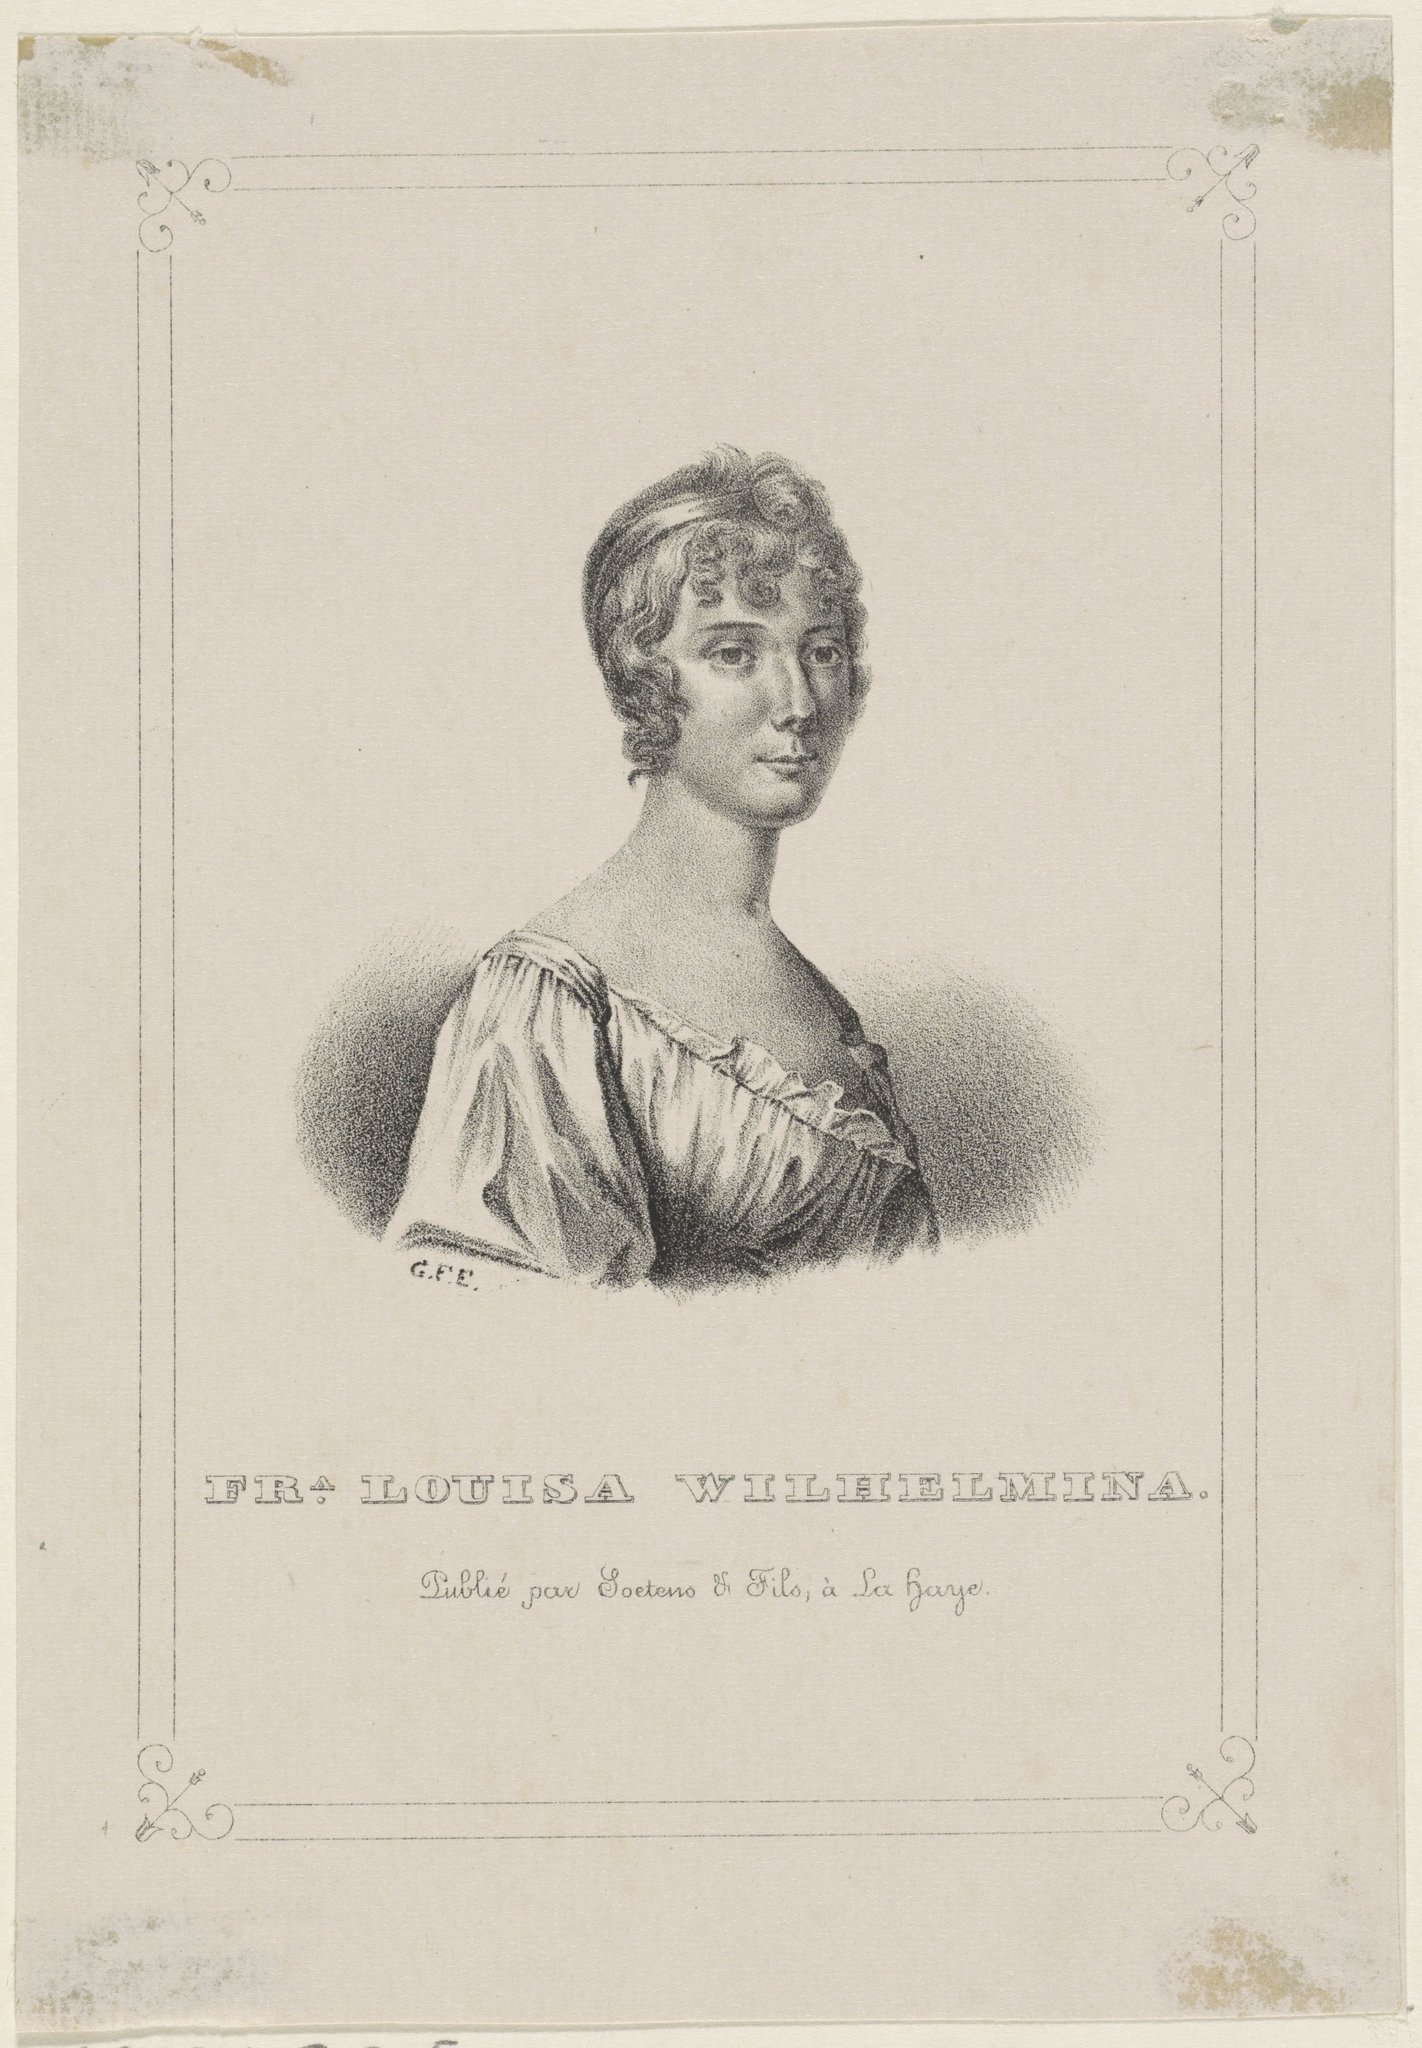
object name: print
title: Portret van Louise, prinses van Oranje-Nassau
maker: gerhardus fredericus eilbracht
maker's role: draughtsman, print maker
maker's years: 1816-1854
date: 1837-1840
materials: paper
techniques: lithograph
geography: the hague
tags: louise (prinses van oranje-nassau)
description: De hier vermelde titel verwijst naar de hoogst verkregen titel van de geportretteerde, niet per se naar de titel die de geportretteerde op deze voorstelling draagt.